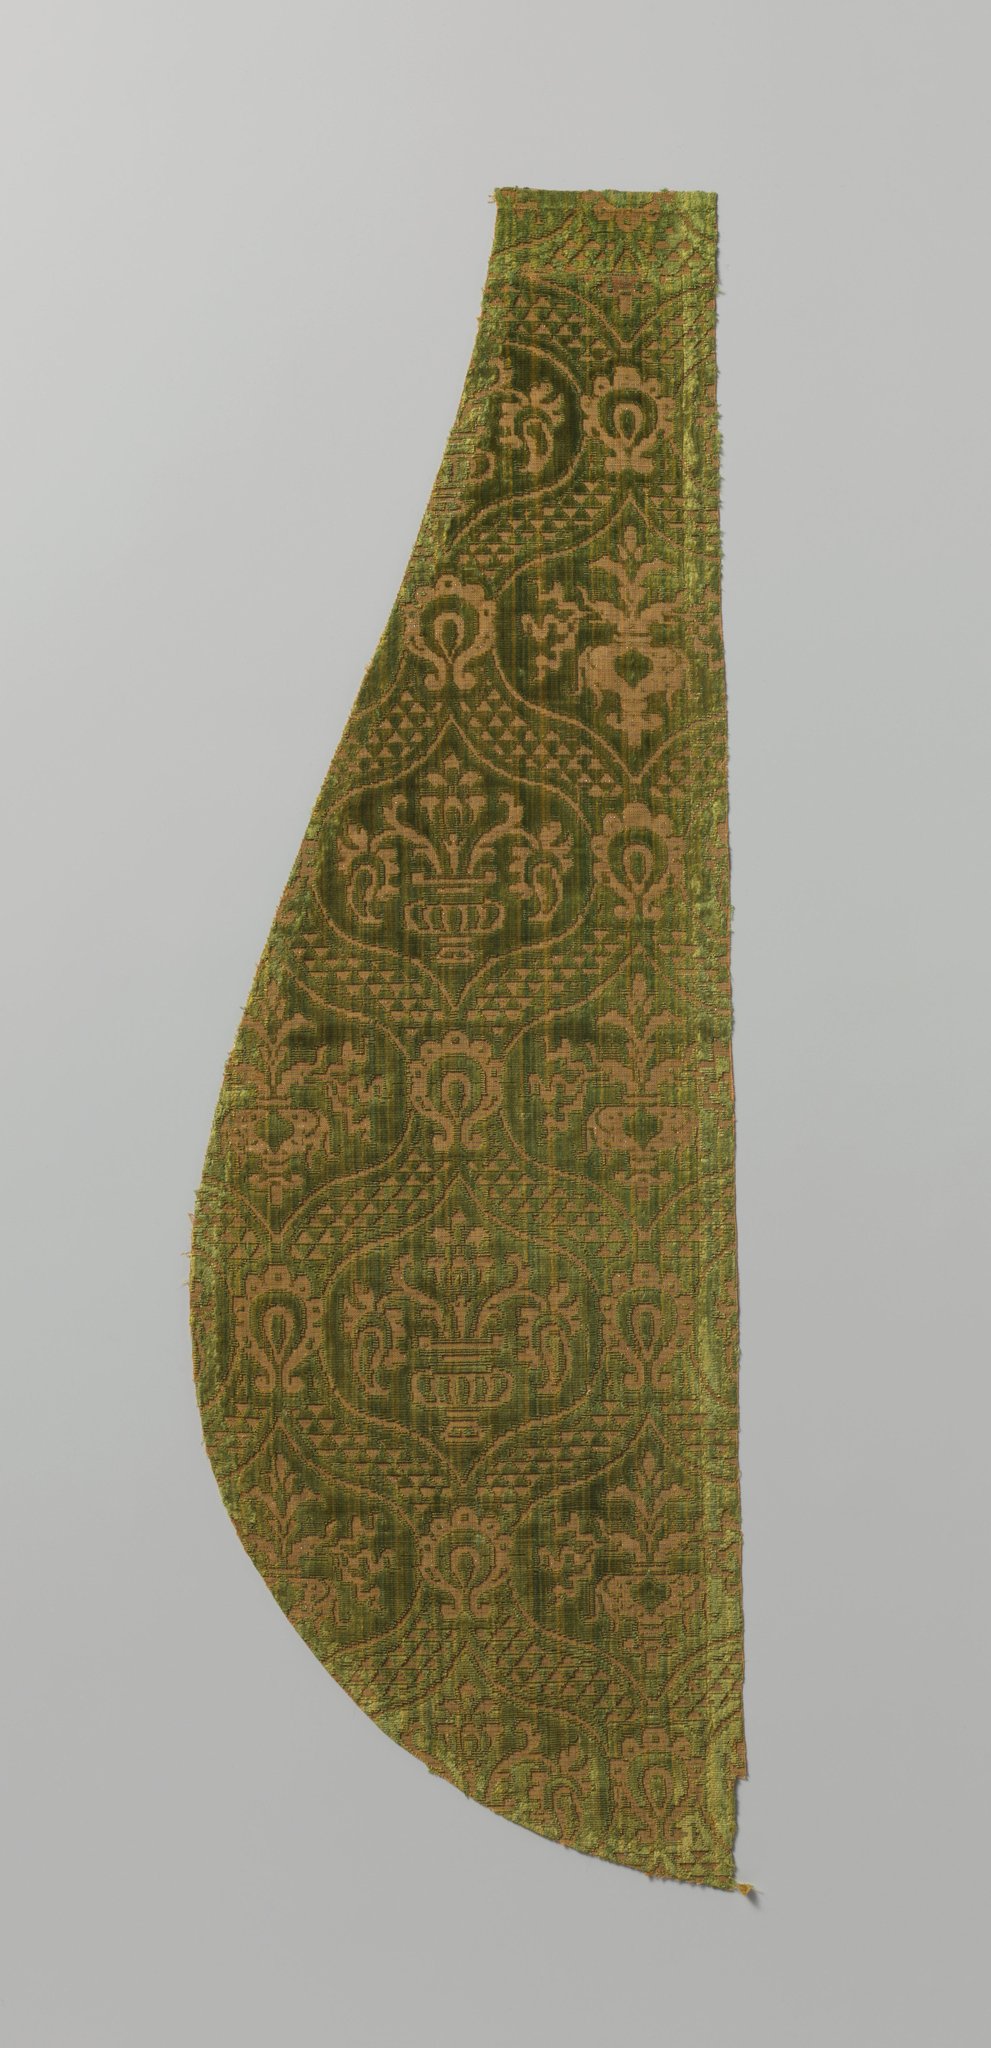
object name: zijdefluweel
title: Fragment zijdefluweel met patroon van spitsovalen waarbinnen gestileerde bloemenvaas, in geel, goud en groen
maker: Anonymous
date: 1500-1599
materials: metal thread, silk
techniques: velvet, weave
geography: italy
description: Fragment zijden fluweel met patroon van spitsovalen waarbinnen gestileerde bloemenvaas, in geel, goud en groen. Waarschijnlijk onderdeel van een liturgisch gewaad.